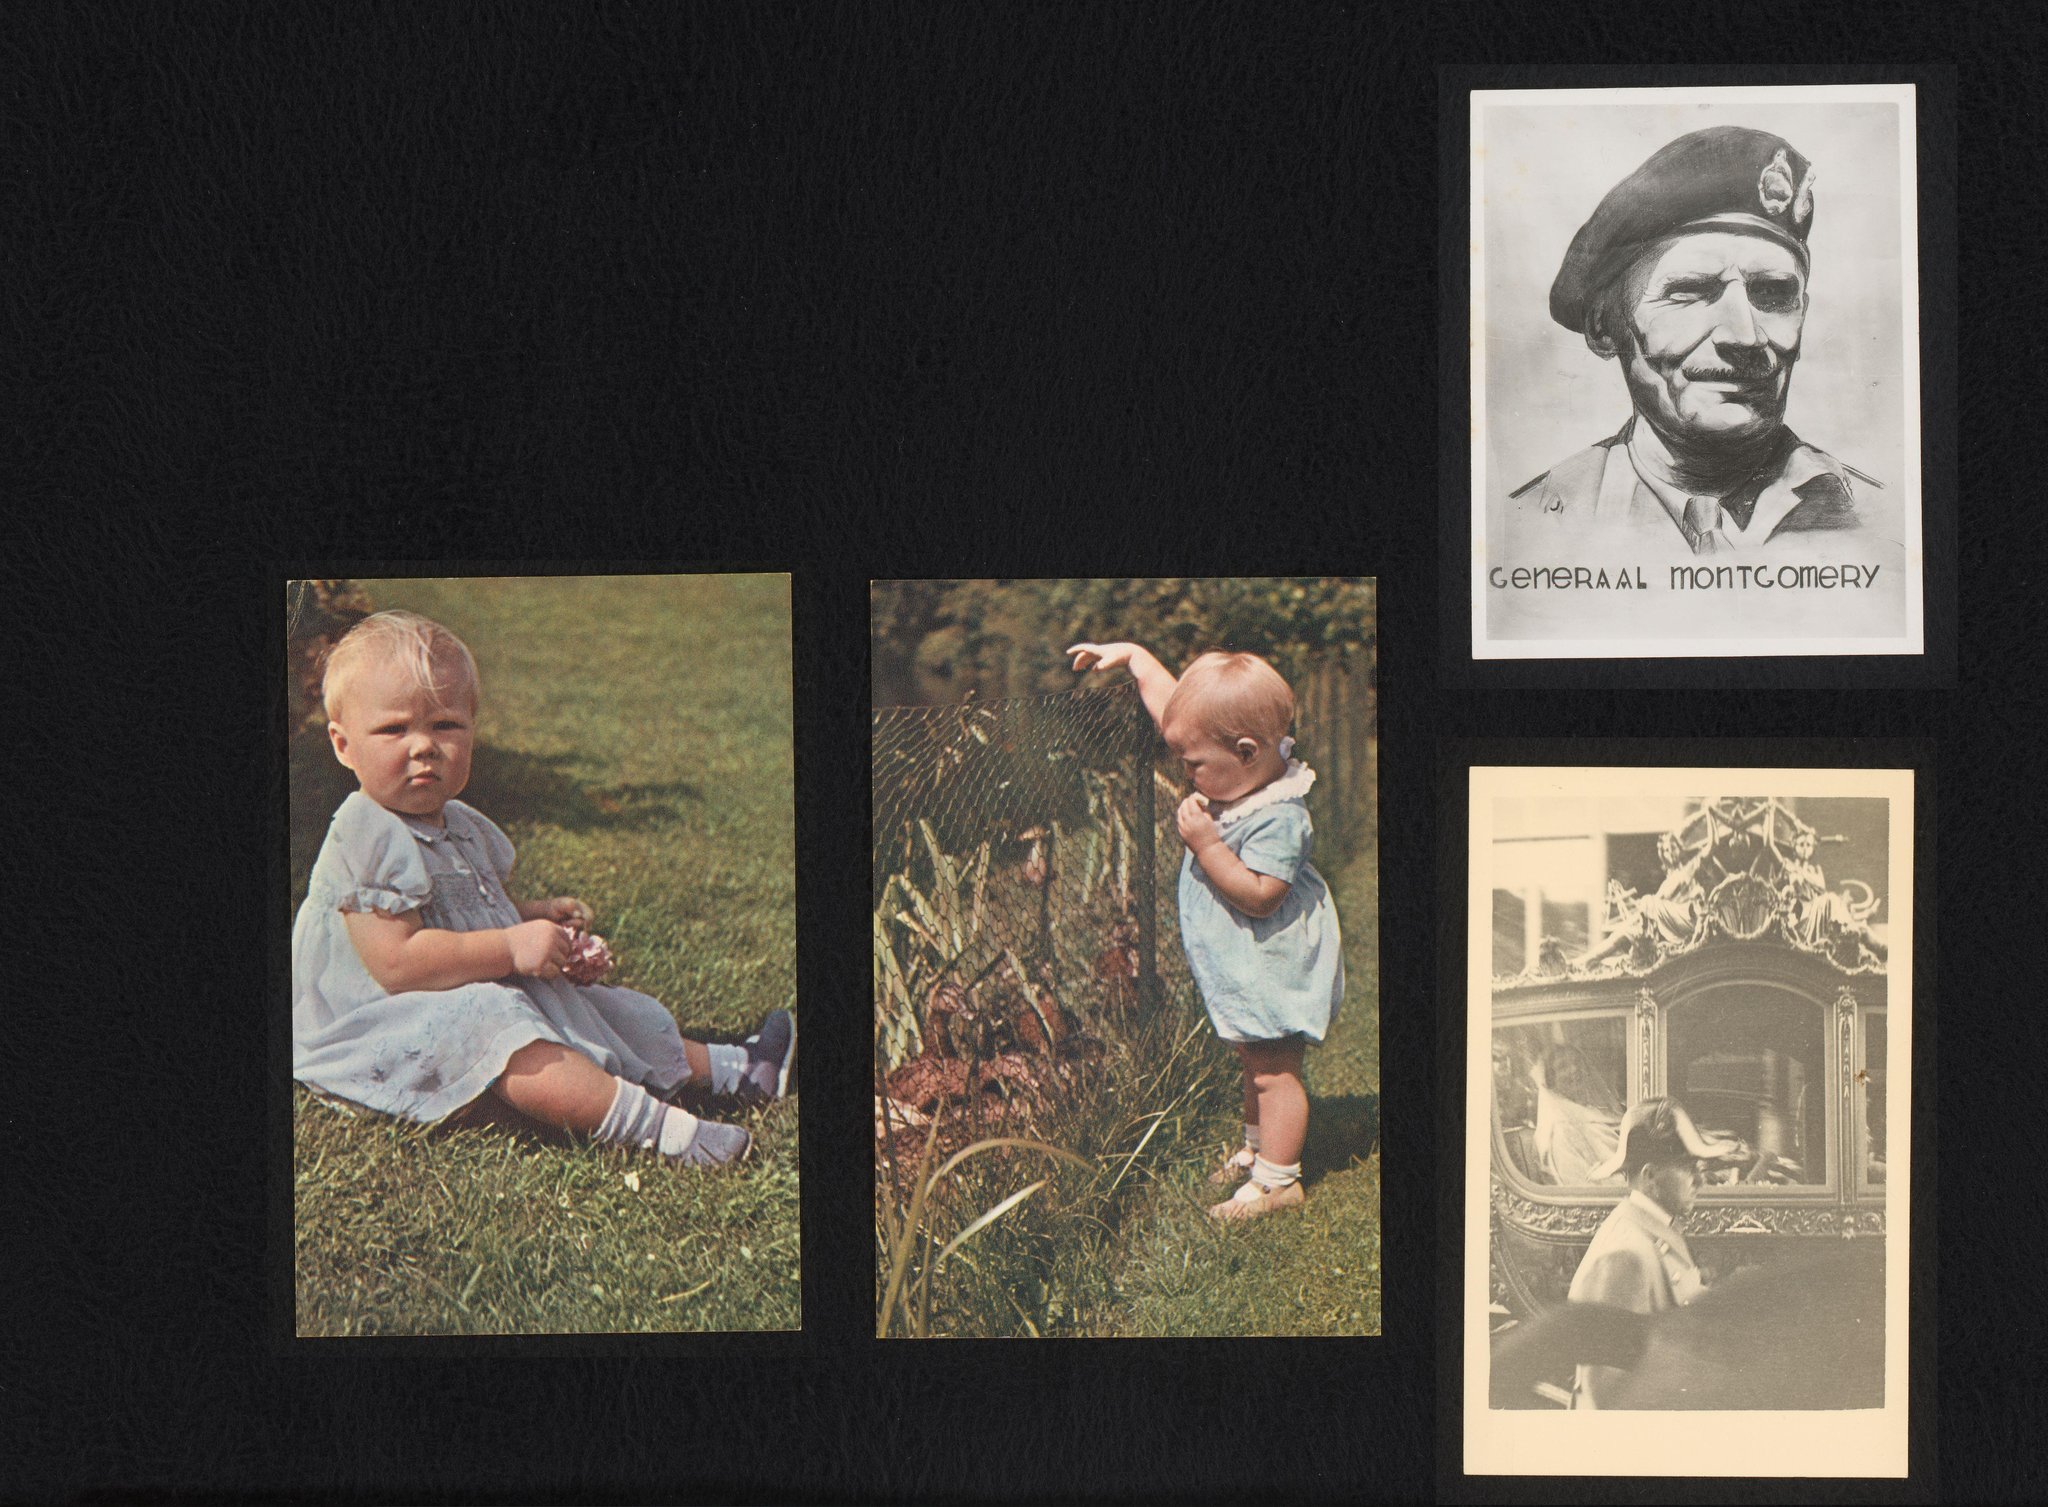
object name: photograph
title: Beatrix, Juliana en Montgomery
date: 1939-1945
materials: paper, photographic support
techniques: gelatin silver print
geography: netherlands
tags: beatrix (koningin der nederlanden), the hague, juliana of the netherlands, playing toddler; child amusing itself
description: Los achterin het album twee melinexmapjes met drie prentbriefkaarten van prinses Beatrix als peuter (zomer 1939) en van prinses Juliana in een koets en een foto van een tekening van generaal Montgomery. Onderdeel van het fotoalbum over de familie van Oranje-Nassau ten tijde van de Tweede Wereldoorlog.